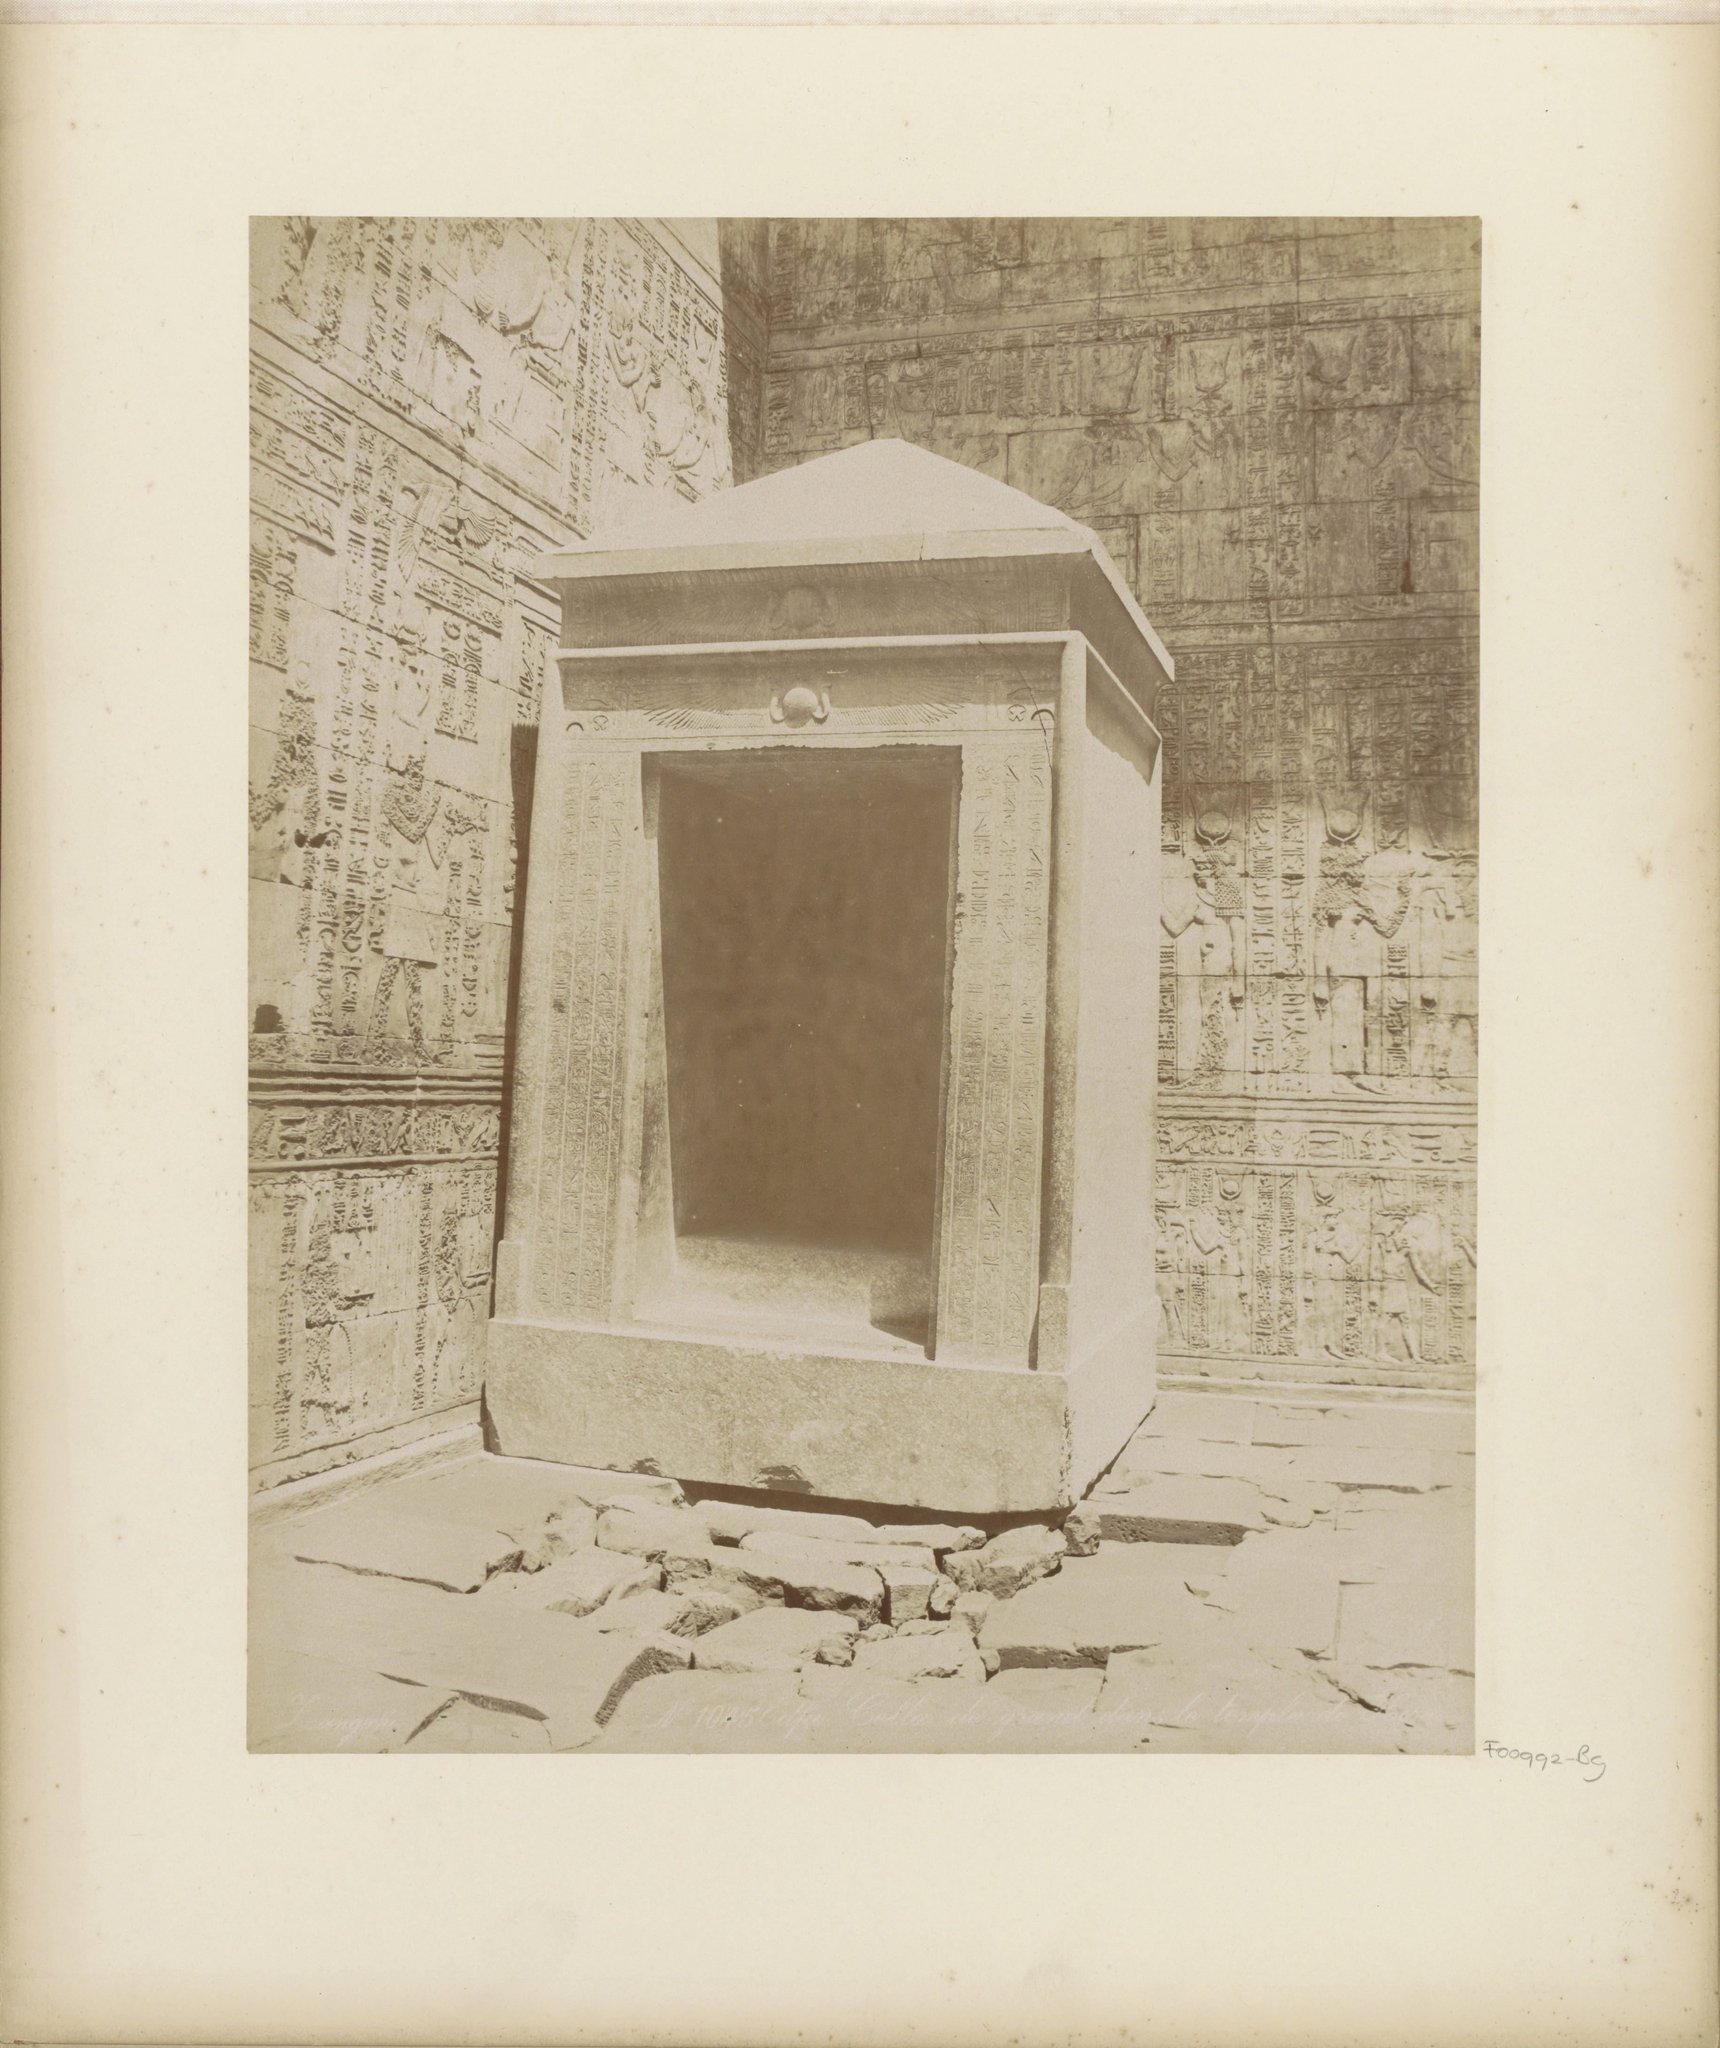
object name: photograph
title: Interieur van de Tempel van Horus in Edfu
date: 1870-1890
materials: cardboard, paper, photographic support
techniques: albumen print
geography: edfu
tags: temple, shrine ~ egyptian religion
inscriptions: negative number: ‘1045’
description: Onderdeel van Reisalbum met 80 foto's van Egypte.